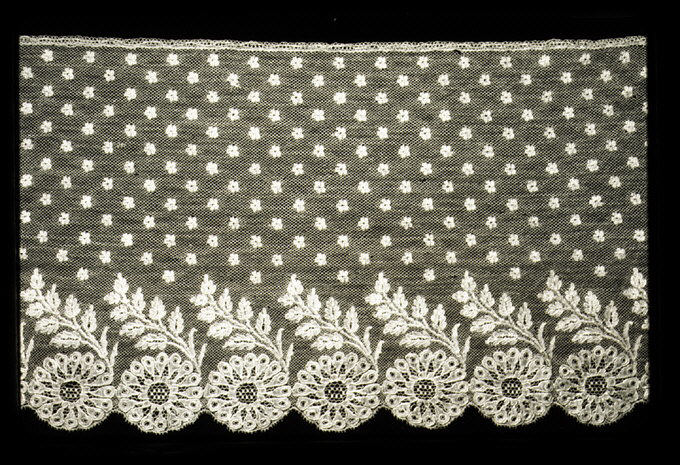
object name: strip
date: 1801-1900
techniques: lace